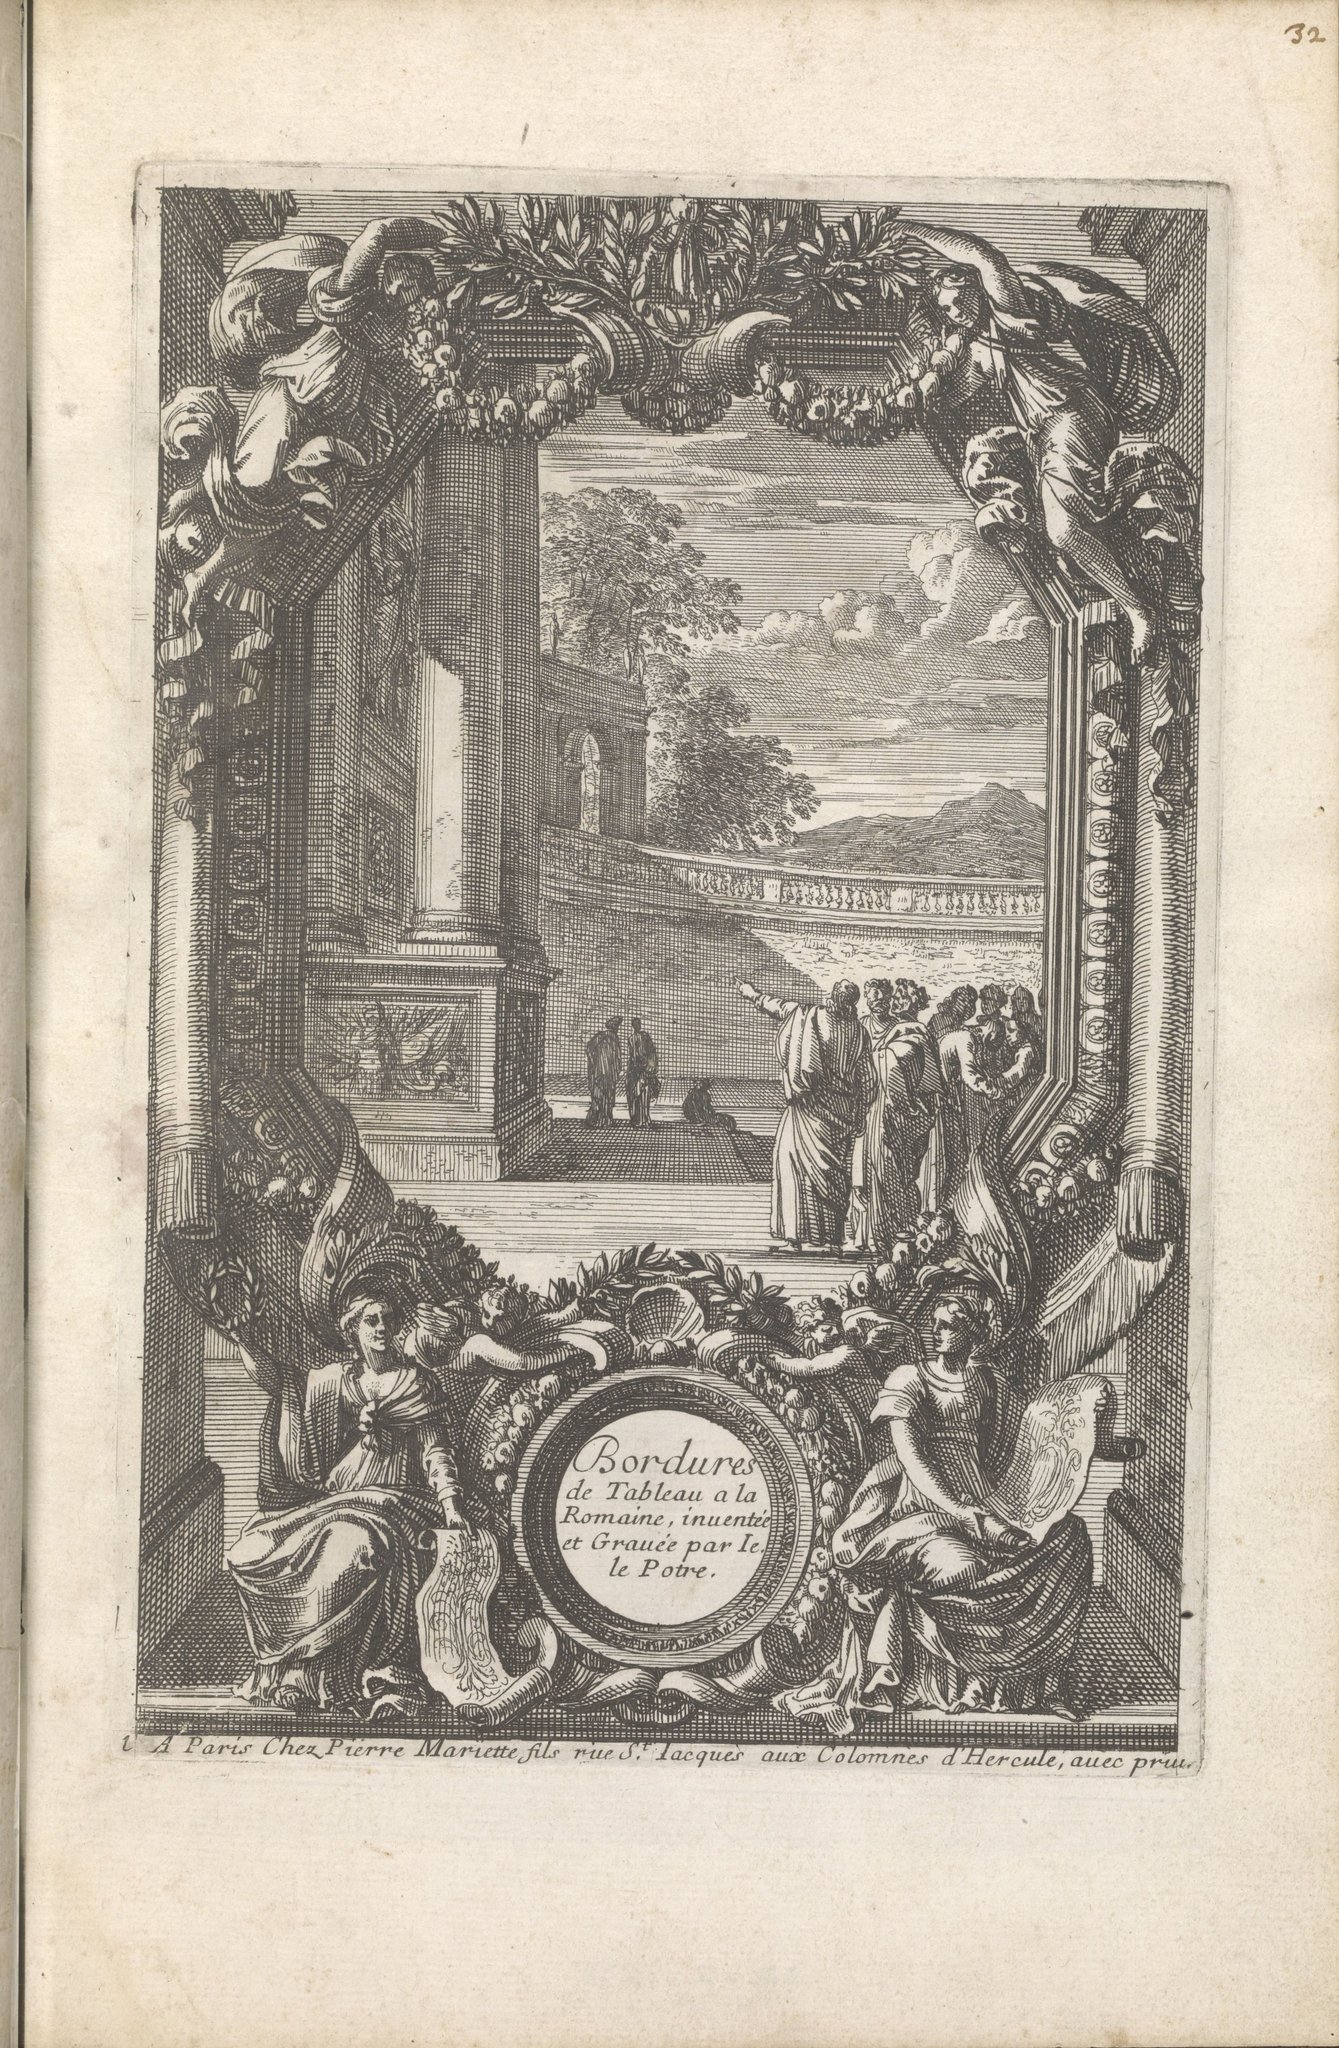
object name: ornament print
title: Zeshoekige omlijsting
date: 1655-1657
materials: paper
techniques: etching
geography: paris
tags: ornaments ~ art, index finger forwards, pointing, indicating, frame of painting, etc.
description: Zeshoekige rijk gedecoreerde lijst met de voorstelling van mensen die opkijken naar een gebouw met monumentale zuilen. Midden onder de serietitel in een medaillon geflankeerd door vrouwen, die ieder een ornamenttekening vasthouden. Prent maakt deel uit van een album.